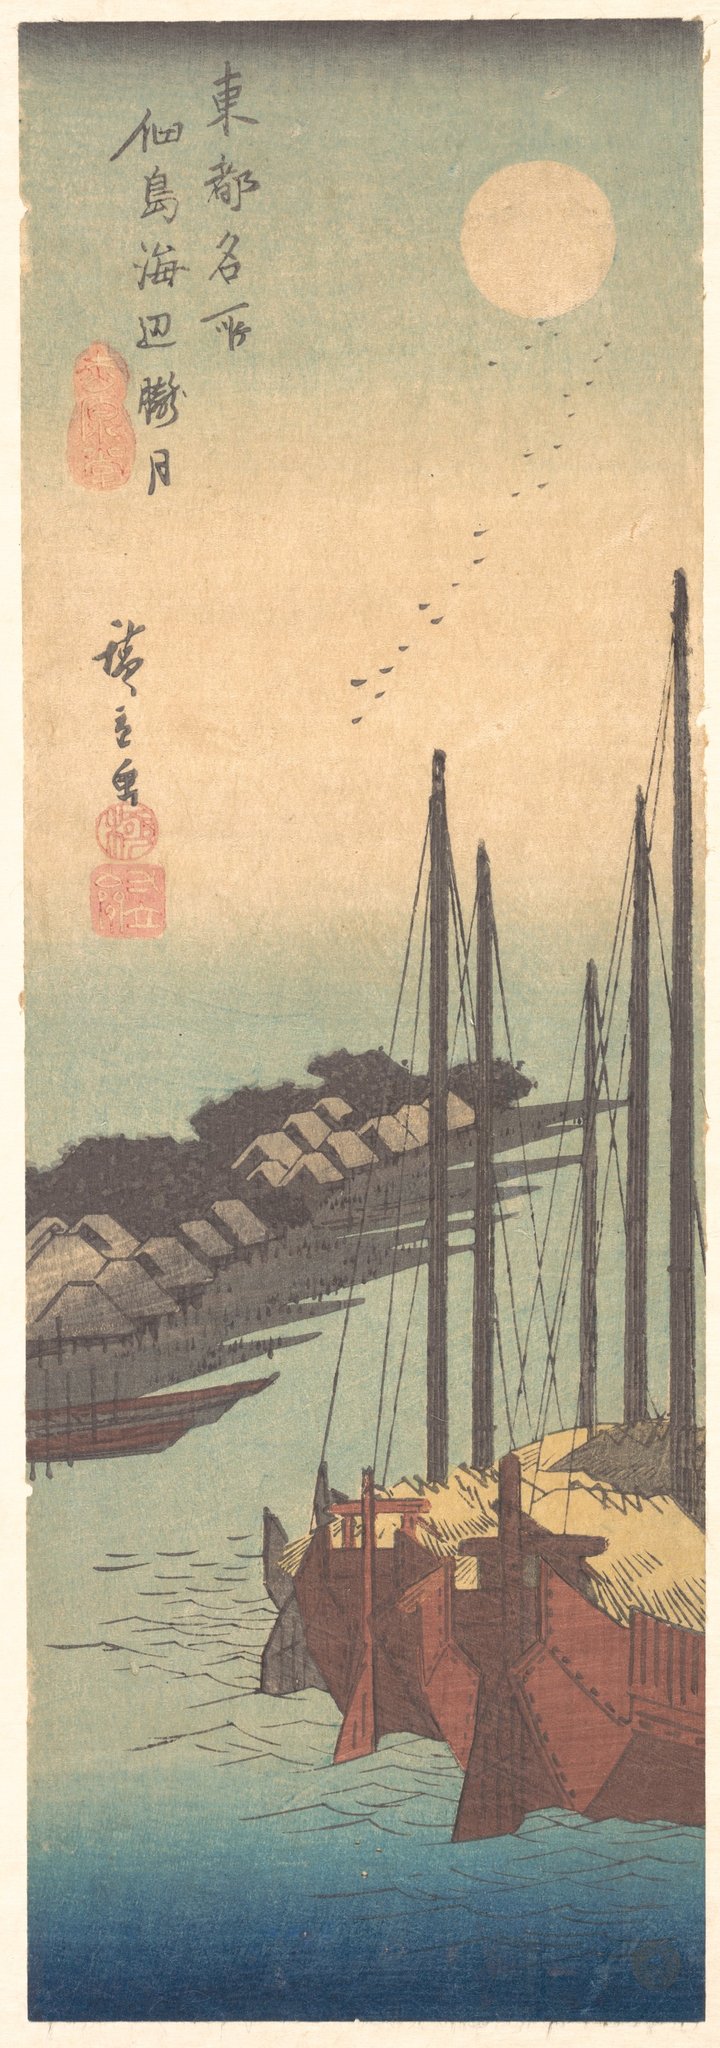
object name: print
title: Tsukudajima Kaihin Rōgetsu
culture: japanese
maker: utagawa hiroshige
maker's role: artist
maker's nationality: japanese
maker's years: 1797-1858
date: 1836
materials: ink, paper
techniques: woodblock print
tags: landscapes,boats